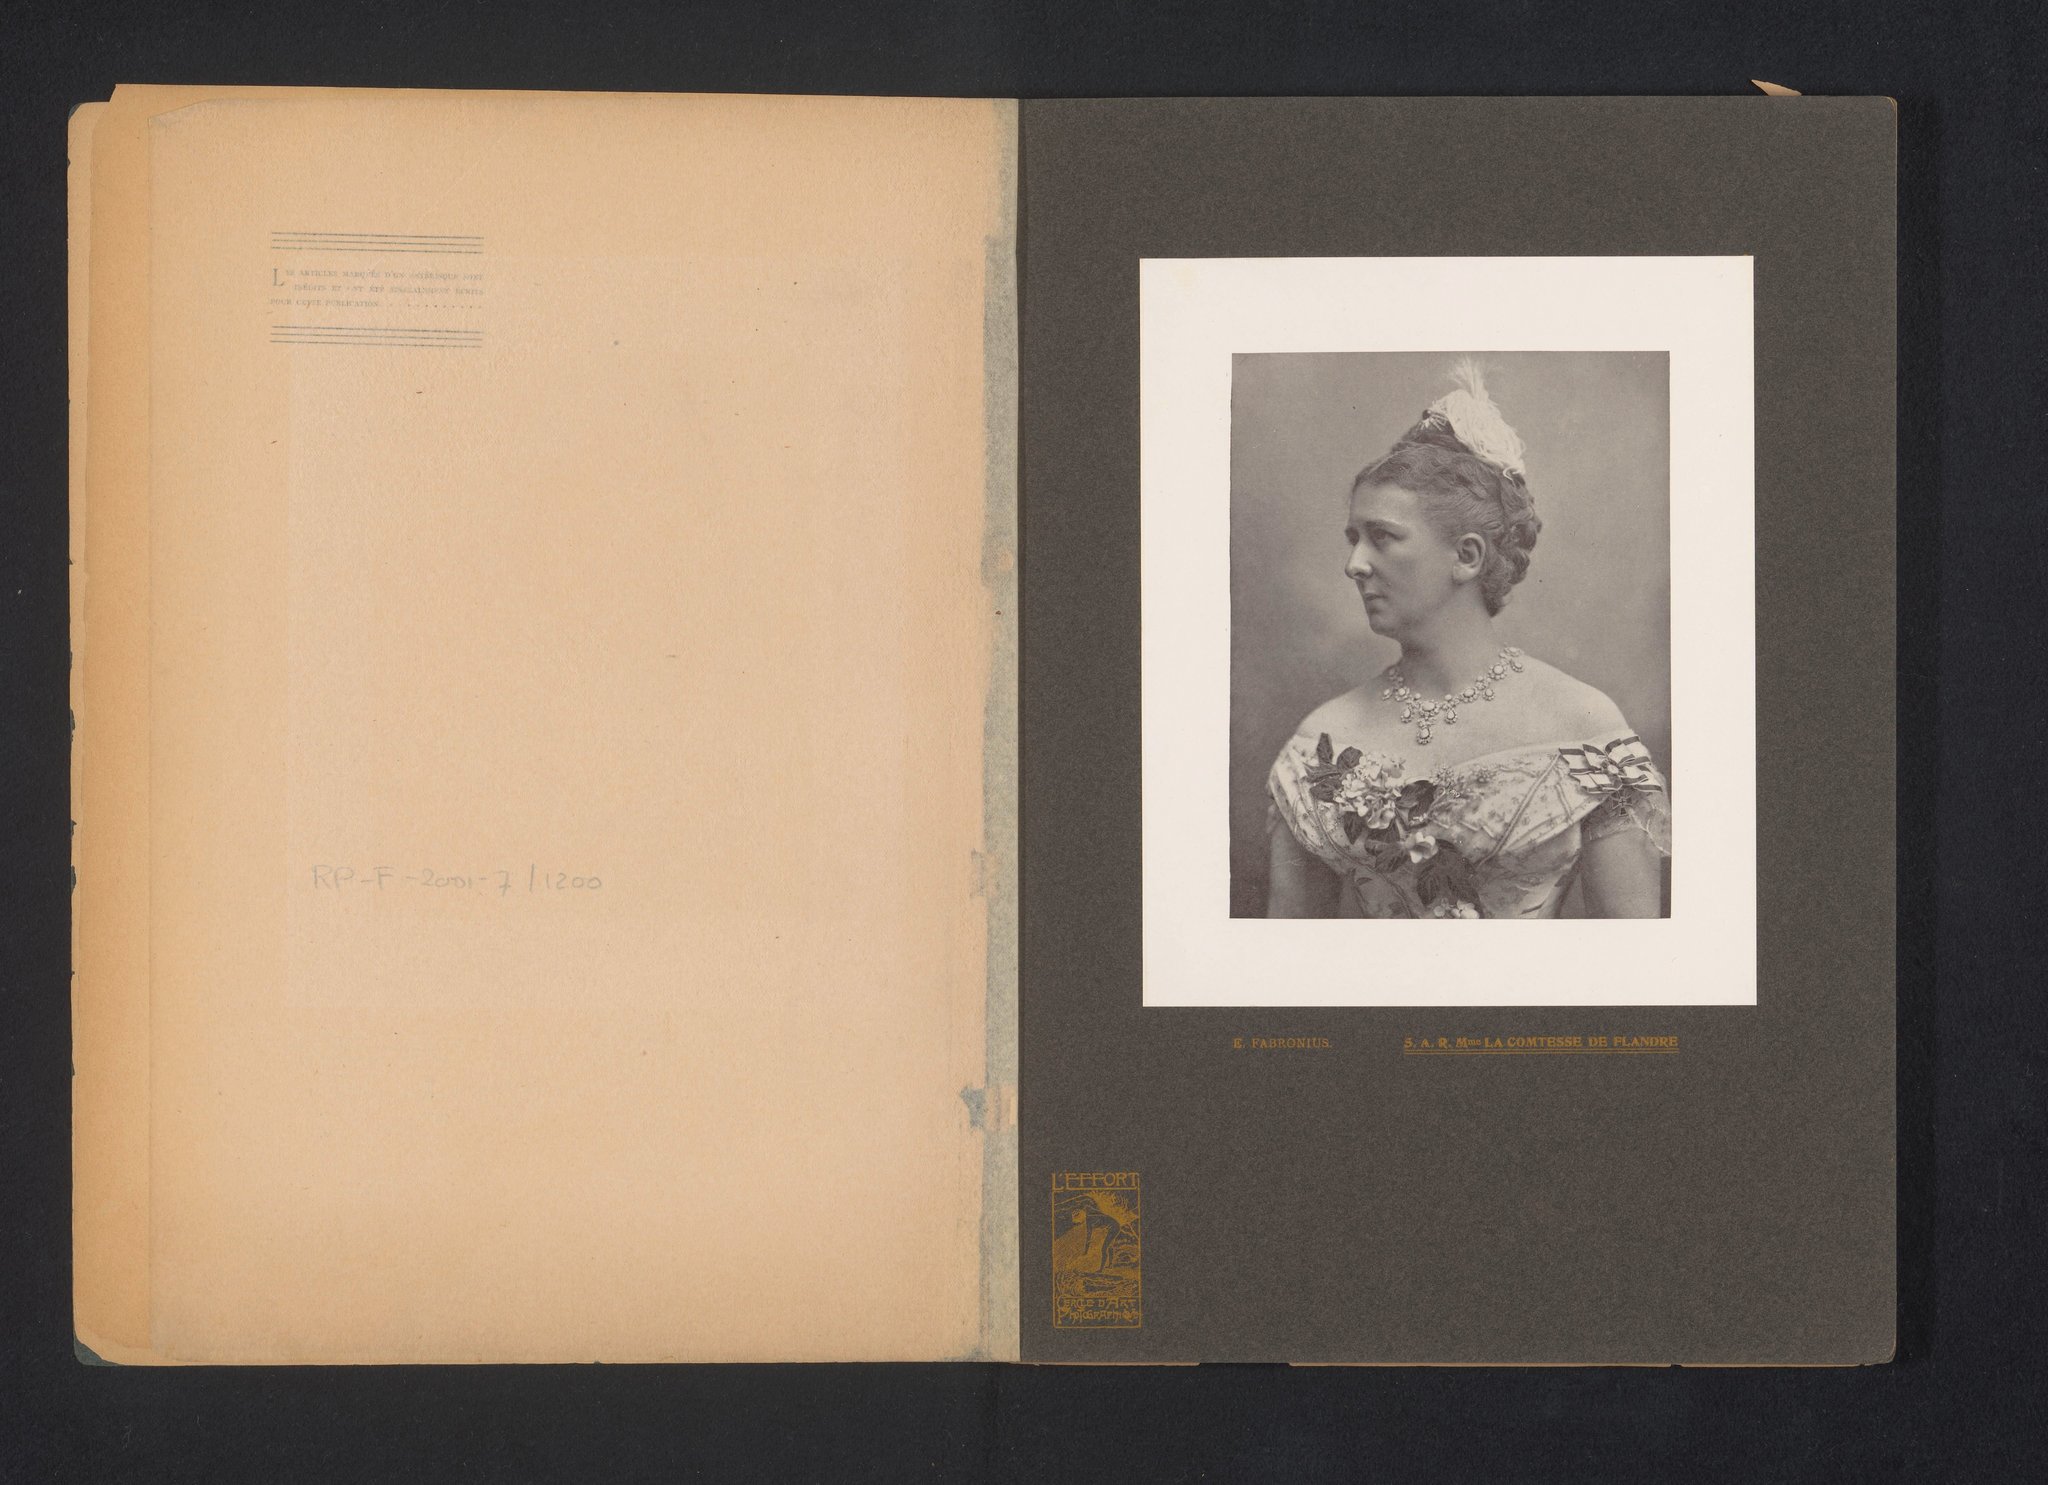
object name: photomechanical print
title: Portret van een vrouw, vermoedelijk gravin Maria van Hohenzollern-Sigmaringen van Vlaanderen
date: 1896-1901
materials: paper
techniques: autotype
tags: brussels, print maker, maria van hohenzollern-sigmaringen (gravin van vlaanderen), historical persons - bb - woman